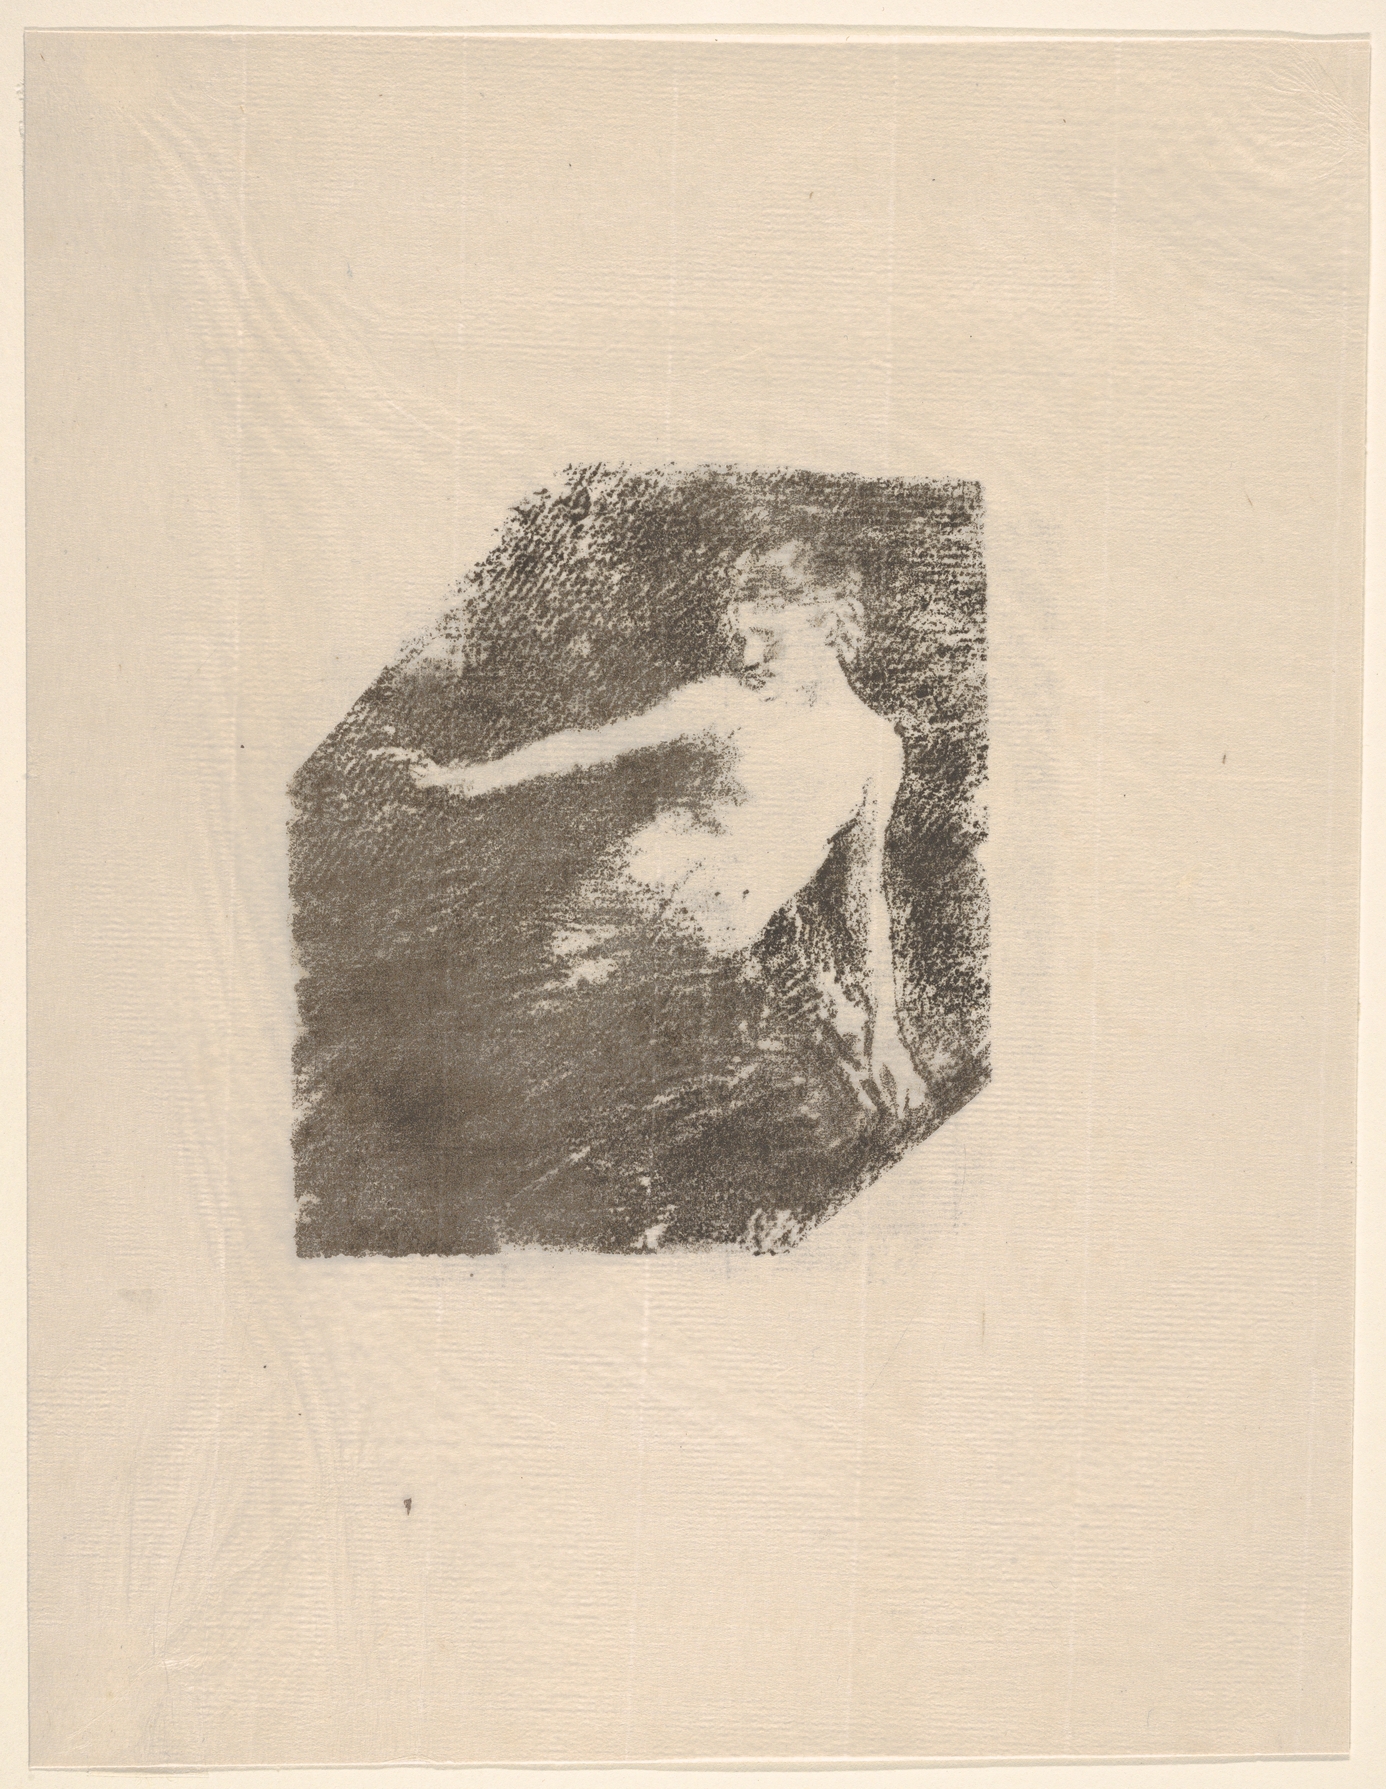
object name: print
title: Naiade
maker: henri fantin-latour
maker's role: artist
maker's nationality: french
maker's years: 1836-1904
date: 1801-2000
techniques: lithograph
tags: nymphs